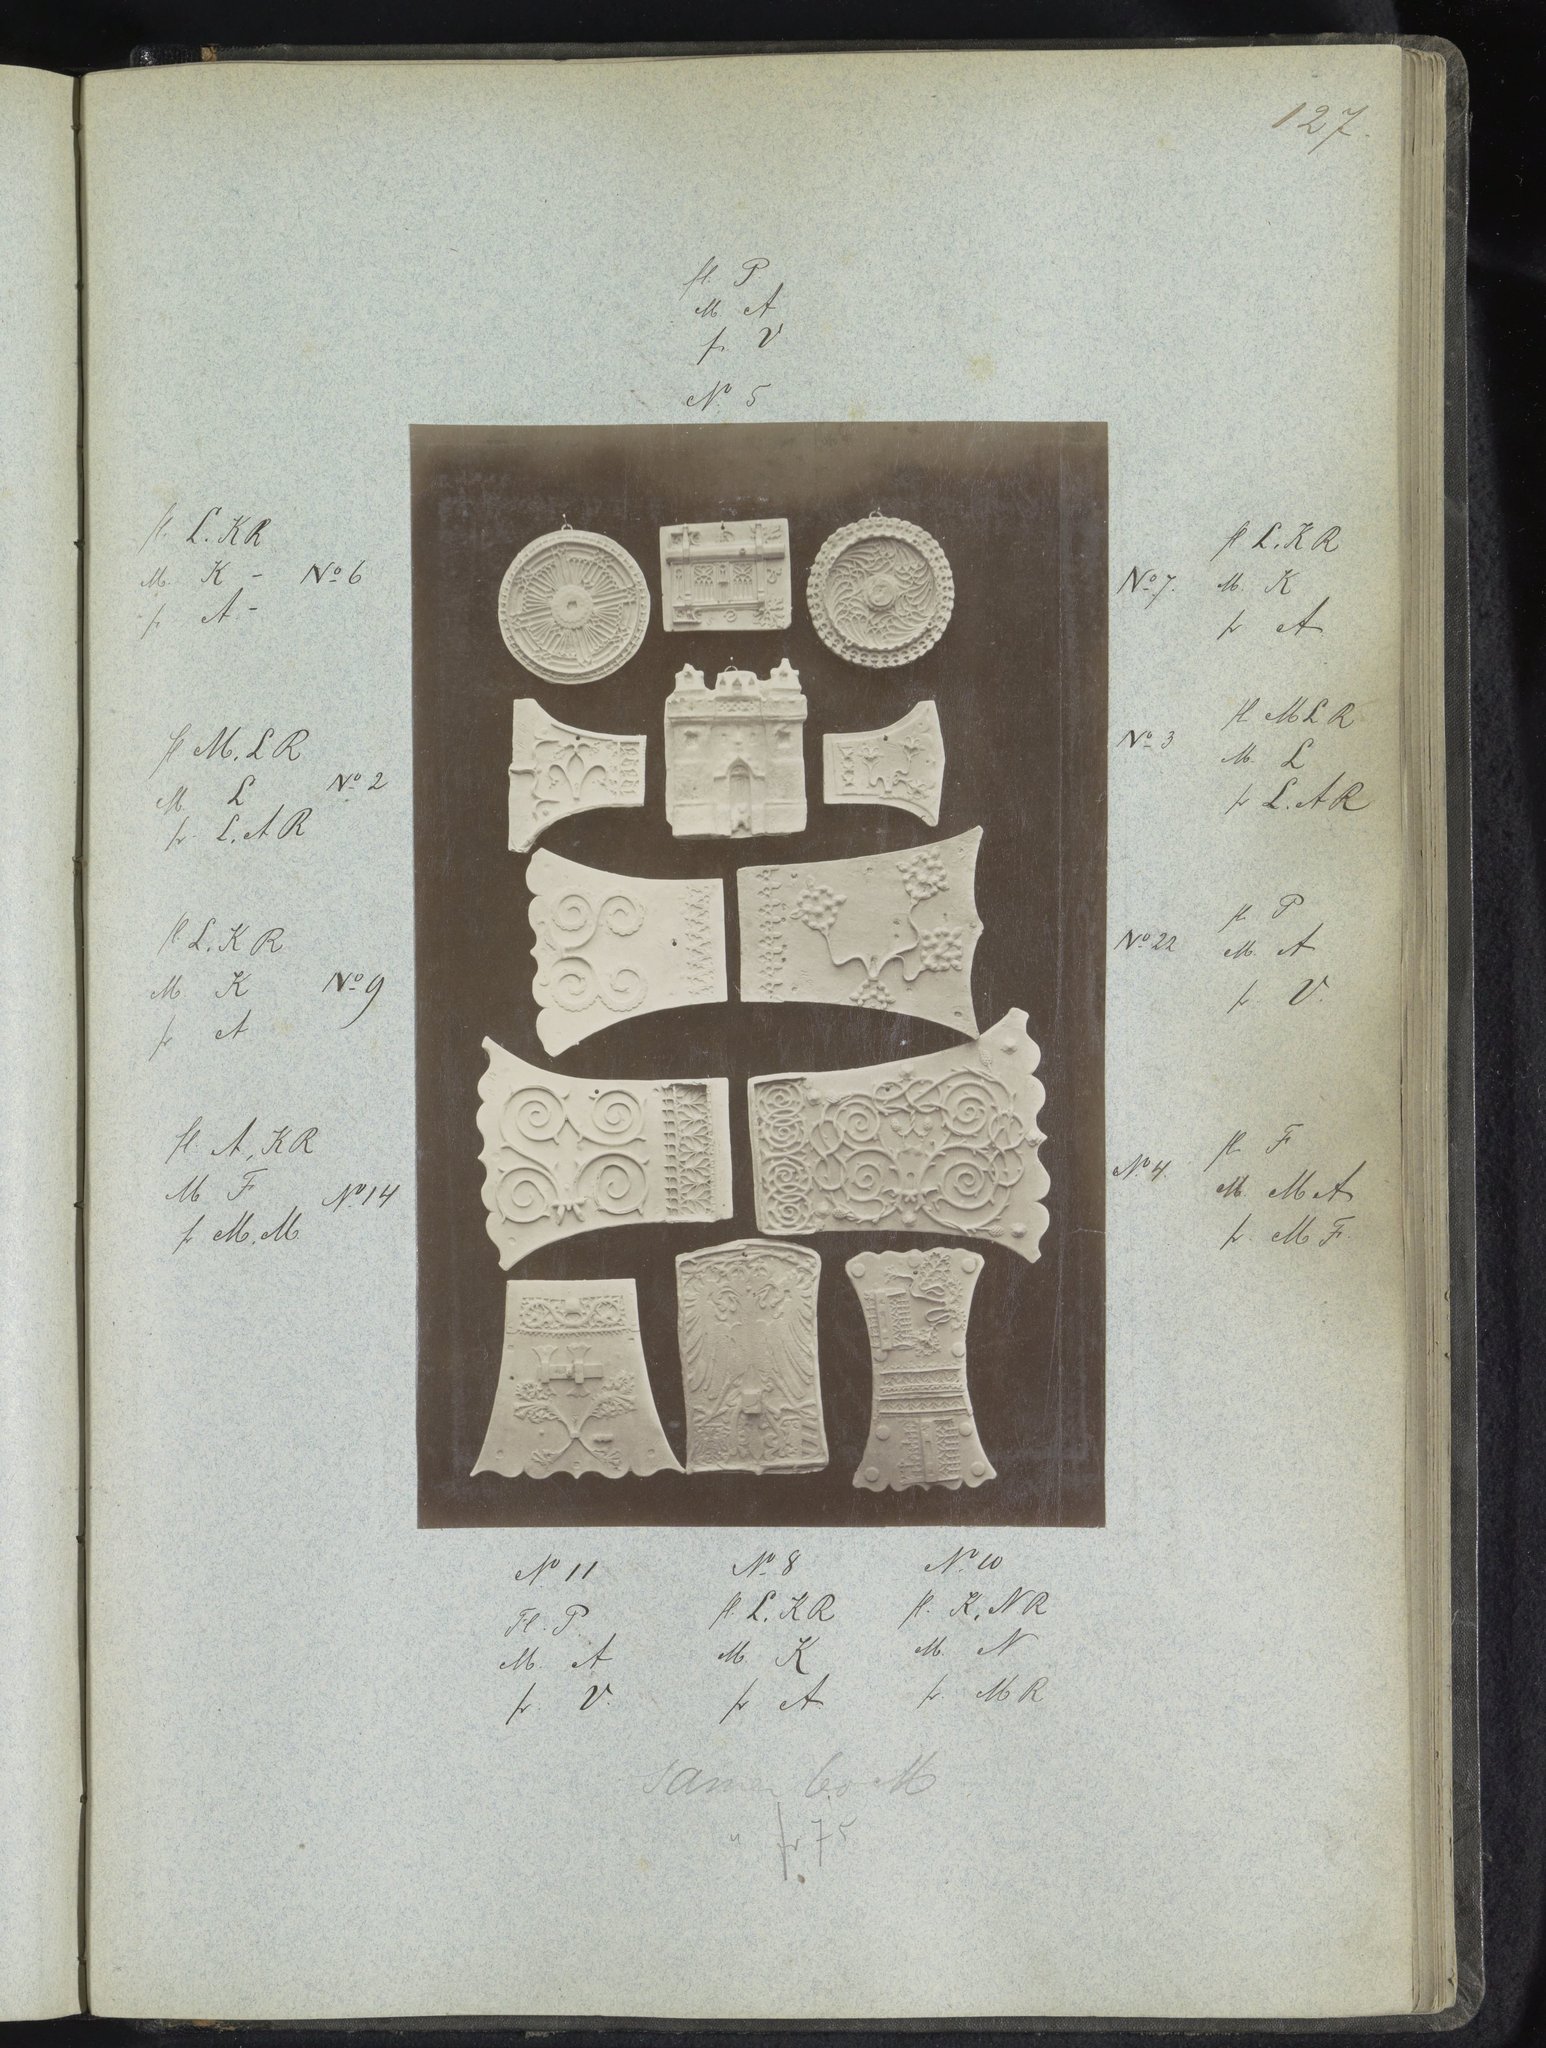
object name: album leaf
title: Dertien gipsen afgietsels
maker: Anonymous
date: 1875-1900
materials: paper, photographic support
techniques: albumen print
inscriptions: annotation